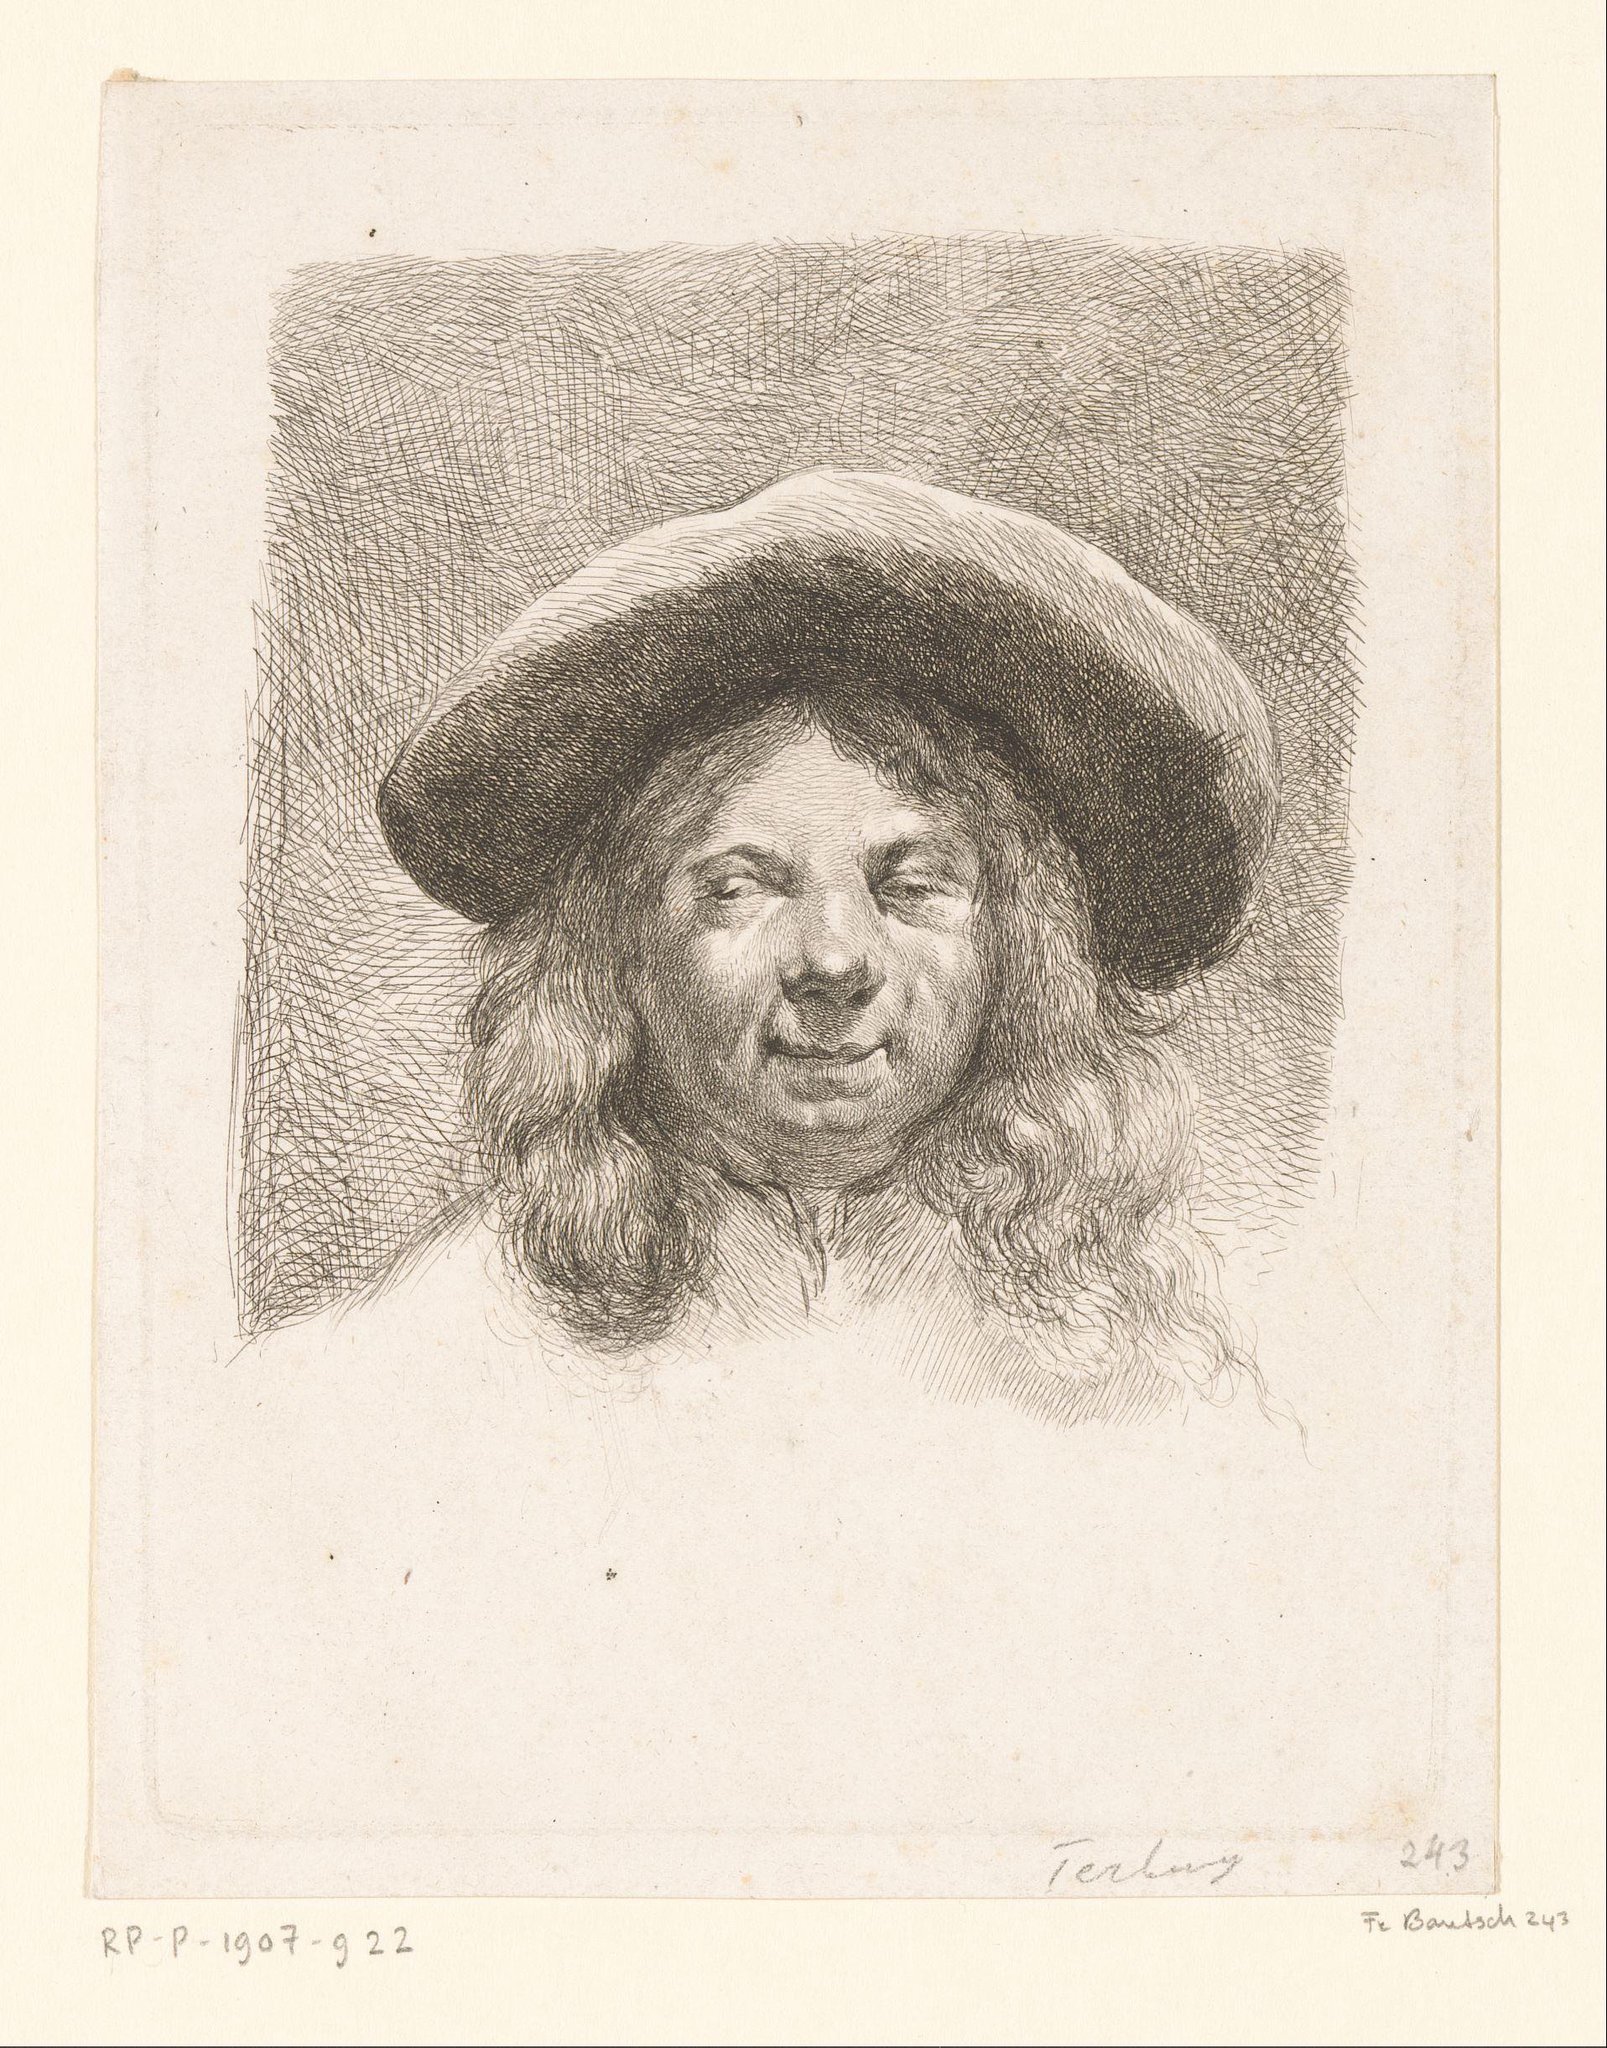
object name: print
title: Portret van Moses ter Borch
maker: adam von bartsch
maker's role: print maker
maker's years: 1757-1821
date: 1803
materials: paper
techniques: etching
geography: vienna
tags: draughtsman, moses ter borch, portrait, self-portrait of artist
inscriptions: collector's mark: Lugt 2228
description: Voorheen werd deze prent geïdentificeerd als het portret van Gerard II ter Borch.